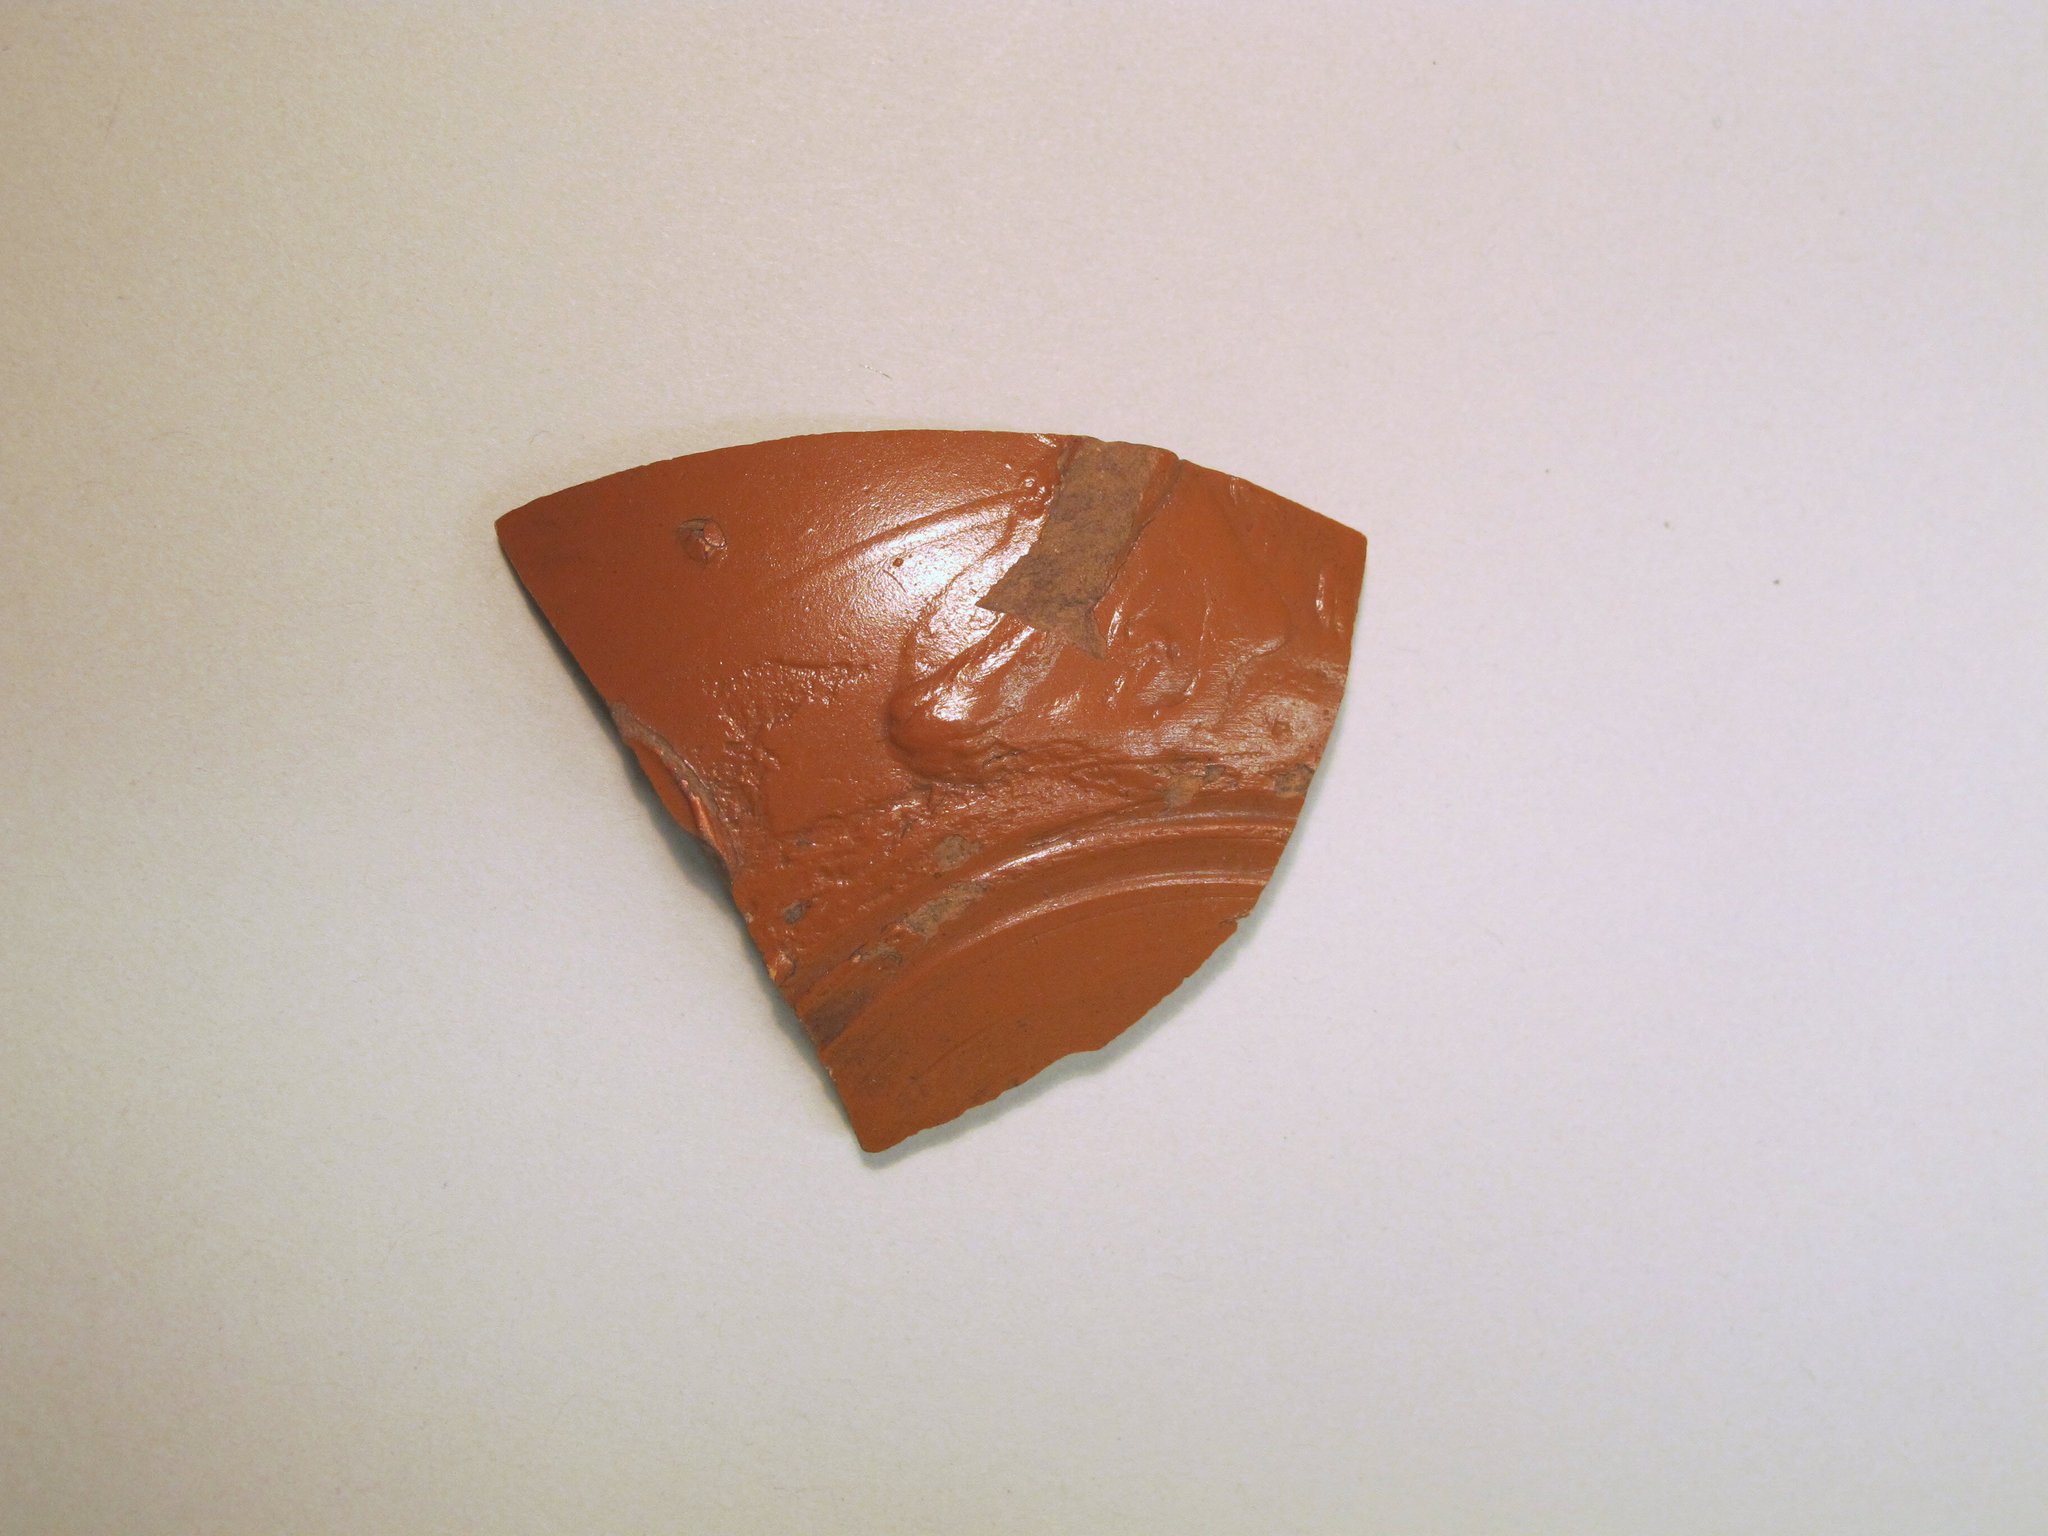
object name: vase fragment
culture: roman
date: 670 BCE-330 CE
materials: terracotta